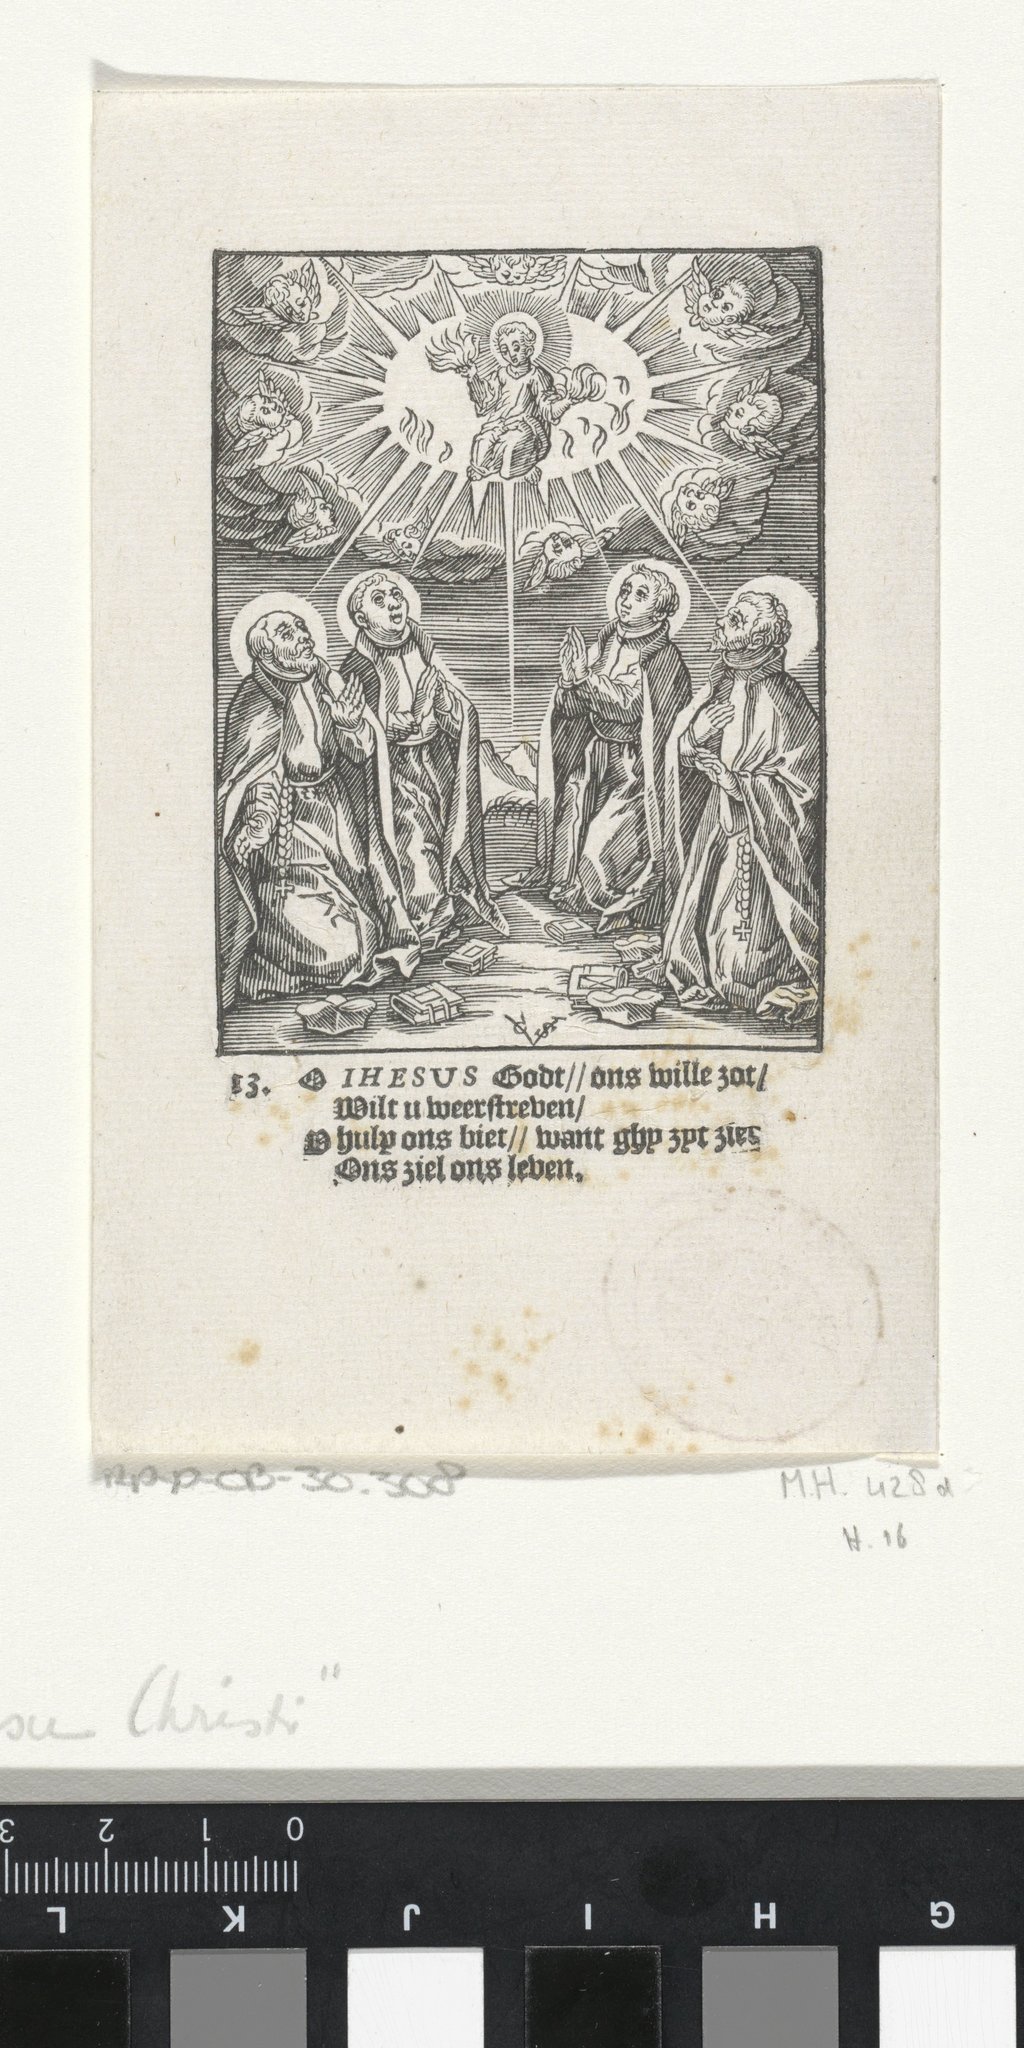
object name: print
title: De kindsheyd onses heeren Iesu Christi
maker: christoffel van sichem (ii)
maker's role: print maker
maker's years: 1581-1658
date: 1617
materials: paper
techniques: letterpress printing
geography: amsterdam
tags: rome, clergyman, missionary, the jesuit friar aloysius gonzaga; possible attributes: crucifix, discipline, lily, skull, christ-child (with attributes), the founder of the jesuit order, ignatius of loyola; possible attributes: book (with 'ad majorem dei gloriam'), demon, dragon under feet, flames, flaming heart, globe, ihs monogram, skull (with crown), tears in eyes, torch, the jesuit missionary francis xavier; possible attributes: cross, crucifix, flaming heart, indian, lily, torch, male saints (with name)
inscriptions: collector's mark: Lugt 240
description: Het Christuskind in een nimbus met in elke hand een vlammend hart, omringd door cherubijnen. Het Kind wordt aanbeden door vier Jezuïeten: Ignatius van Loyola, Francis Xavier, Aloysius Gonzaga en Stanislaus Kostka. In de ondermarge vier regels Nederlandse tekst.